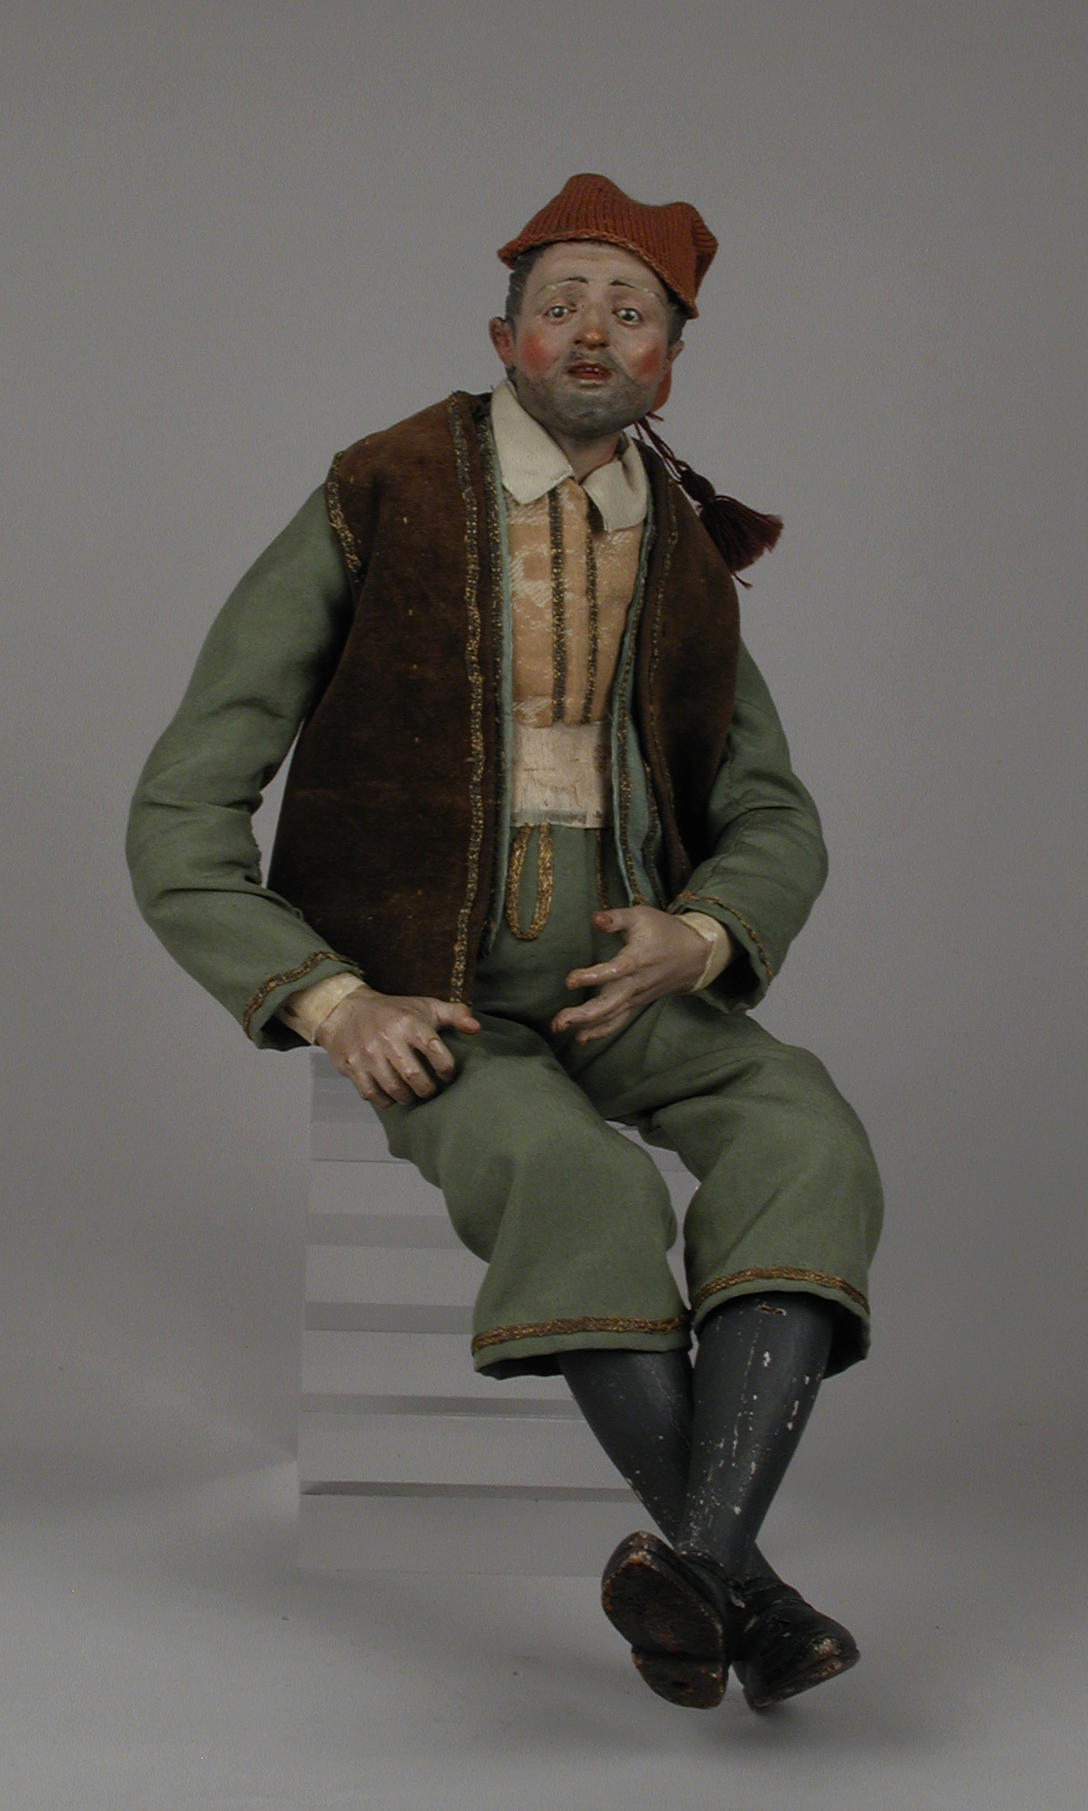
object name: crèche figure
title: Man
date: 1667-1833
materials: glass, silk, terracotta, fiber, metal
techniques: polychrome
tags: men